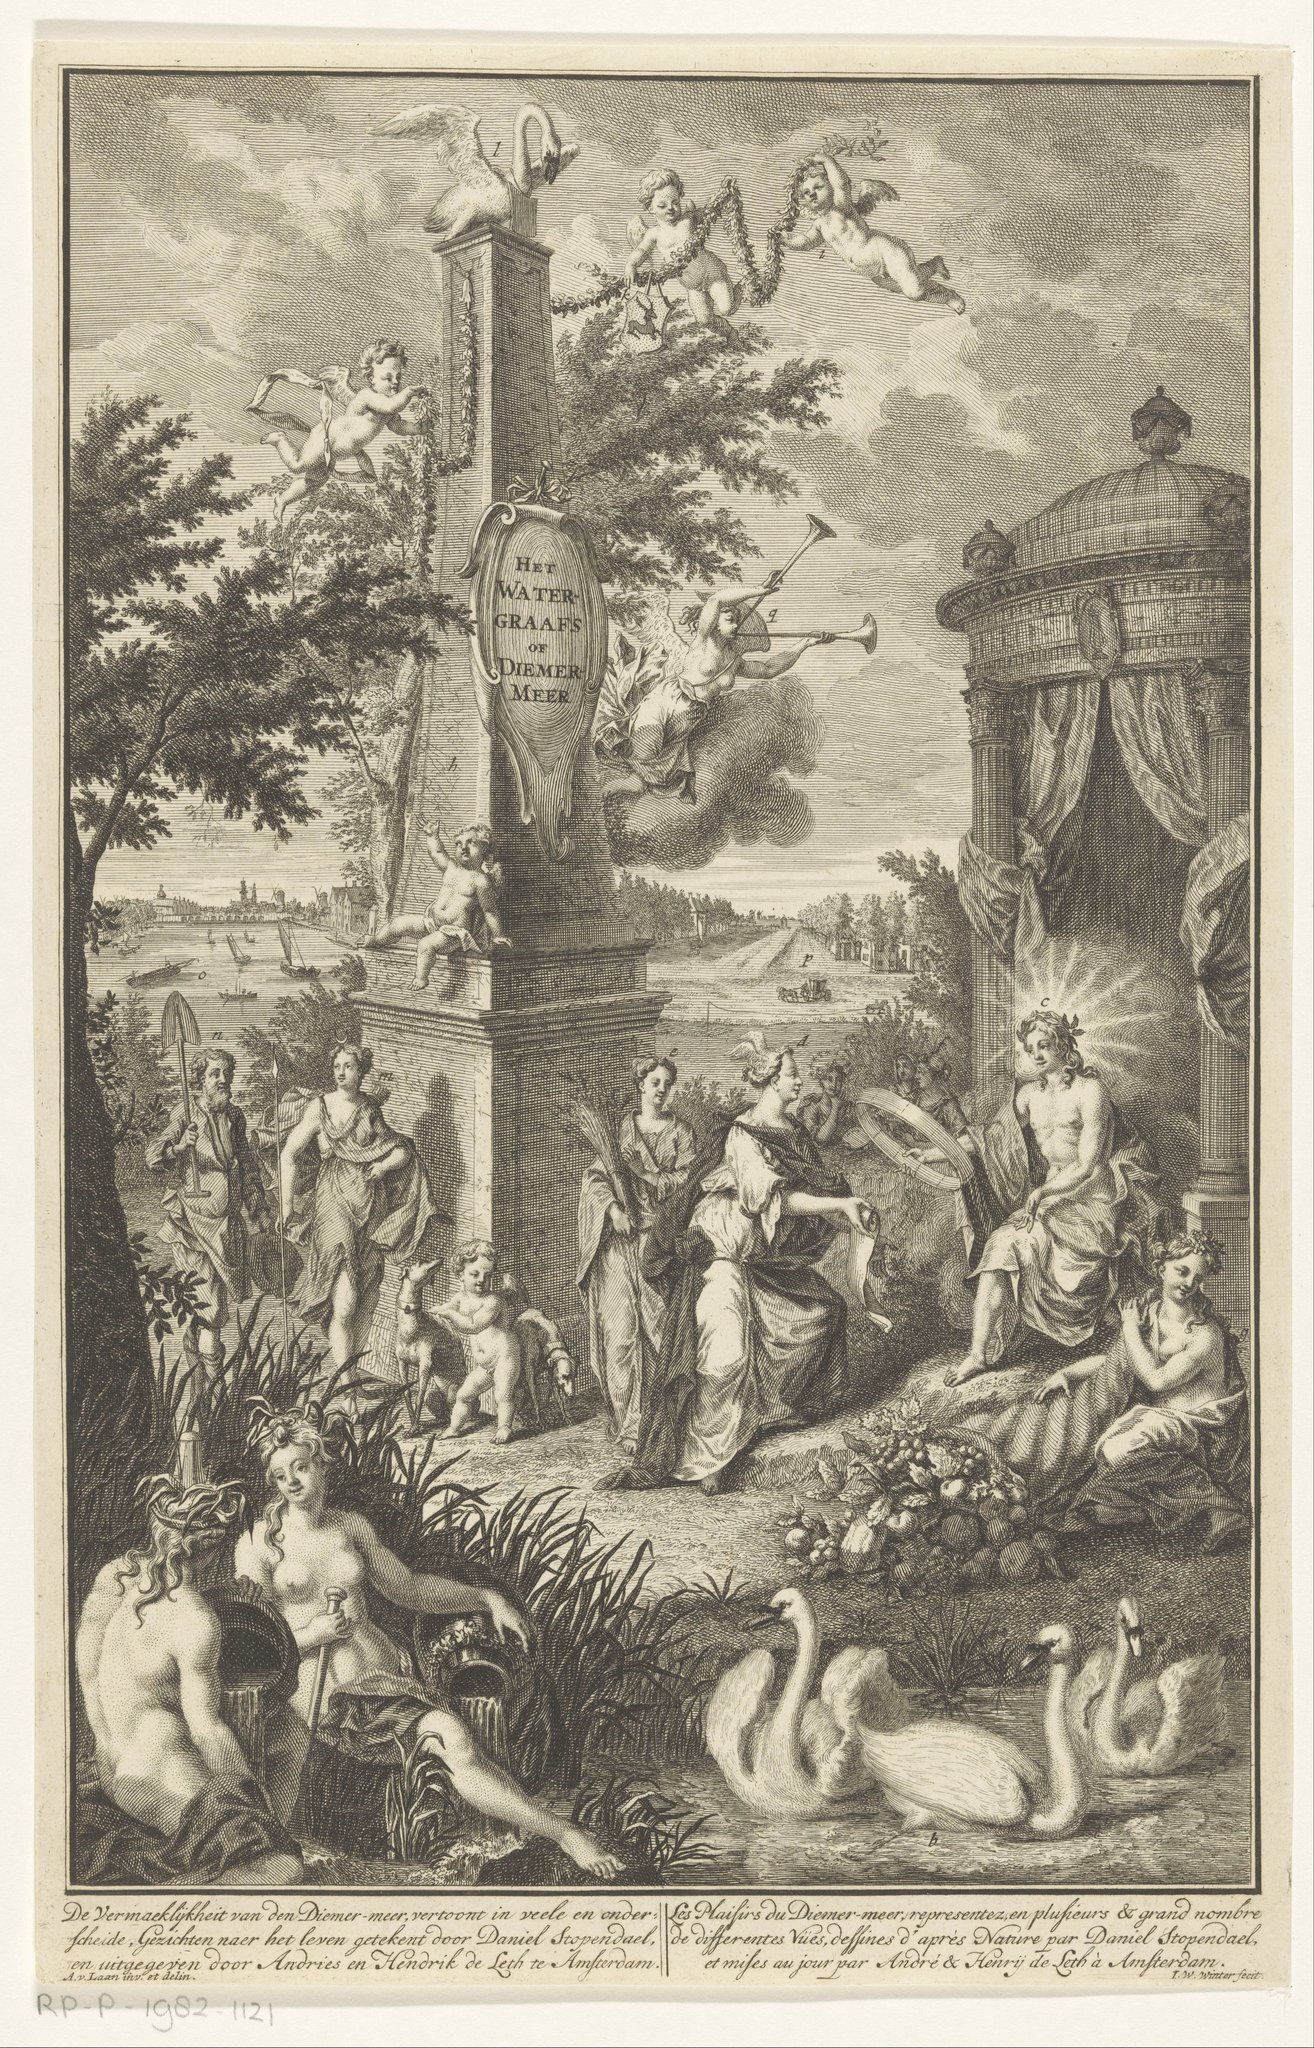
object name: print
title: Titelpagina voor: Matthaeus Brouërius Nidek, Het Watergraefs- of Diemer-meer, 1725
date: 1725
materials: paper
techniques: engraving, etching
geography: amsterdam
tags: 'cornucopia', horn of plenty, river personified, 'fiumi' (ripa), water-birds: swan, polder, reclaimed land, boundary-post, boundary-stone, cupids: 'amores', 'amoretti', 'putti'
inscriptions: collector's mark: Lugt 2228, collector's mark: Lugt 2780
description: Op de voorgrond zitten twee waternimfen als personificaties van de Amstel en het Nieuwe Diep. Rechts onder een baldakijn troont Apollo met de dierenriem in zijn hand. Een vrouw met vleugels aan het hoofd toont hem een rol met ontwerpen. Achter haar staat Ceres met korenschoof. In het midden een obelisk met de boektitel en een zwaan als symbool voor het Diemermeer. Links daarvan staan Diana en een boer. In de achtergrond een zicht op de Amstel en het poldergebied Diemer- of Watergraafsmeer.